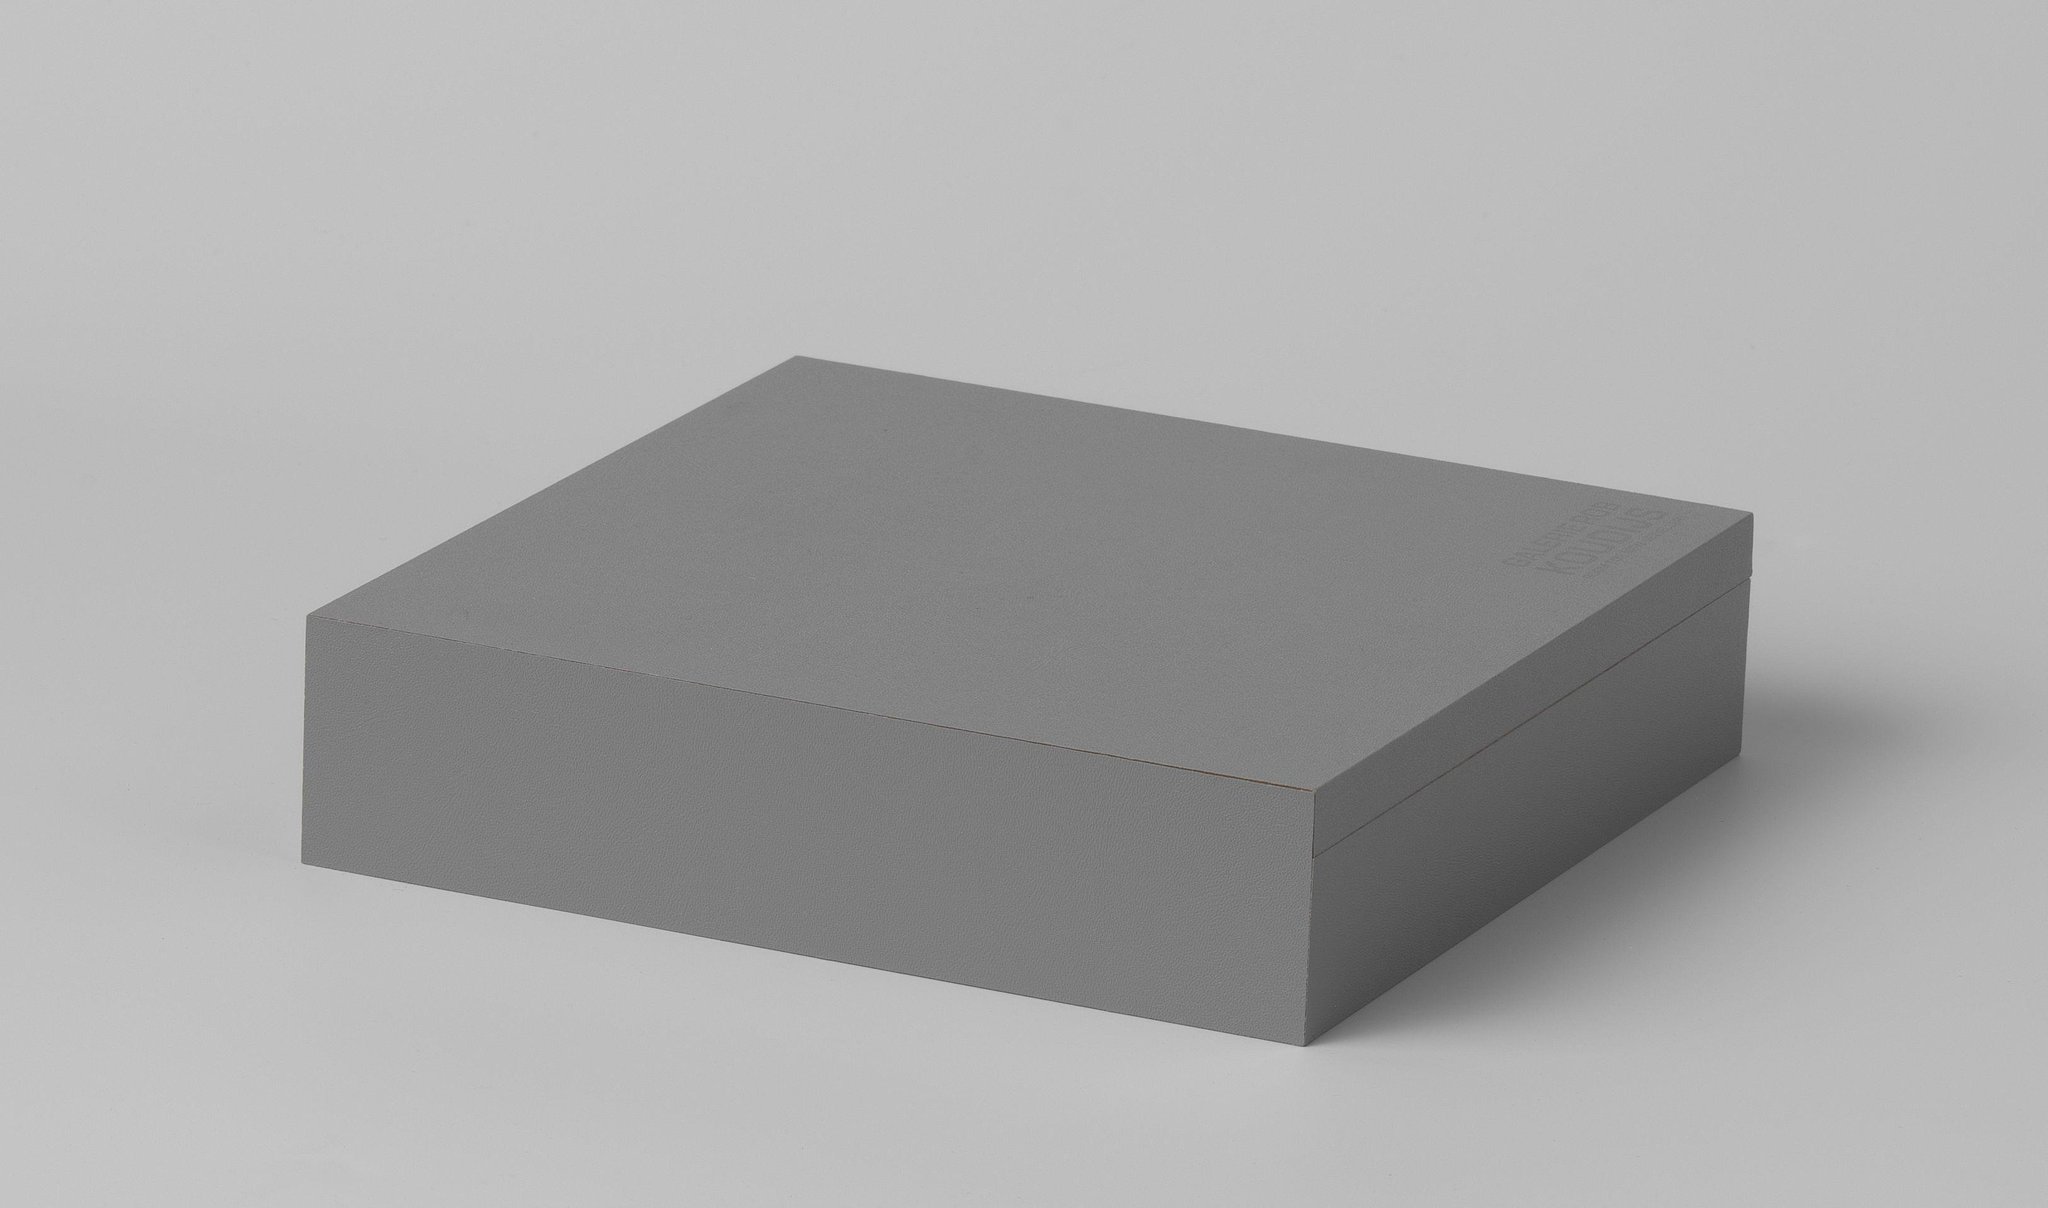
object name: box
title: Doos voor broche van staal en perspex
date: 2015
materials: velvet, wood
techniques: coating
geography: amsterdam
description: Vierkante doos met scharnierend deksel van grijs gecoat geperst hout met bekleding van zwart velours. Op de deksel in zilveren belettering"Galerie Rob Koudijs".